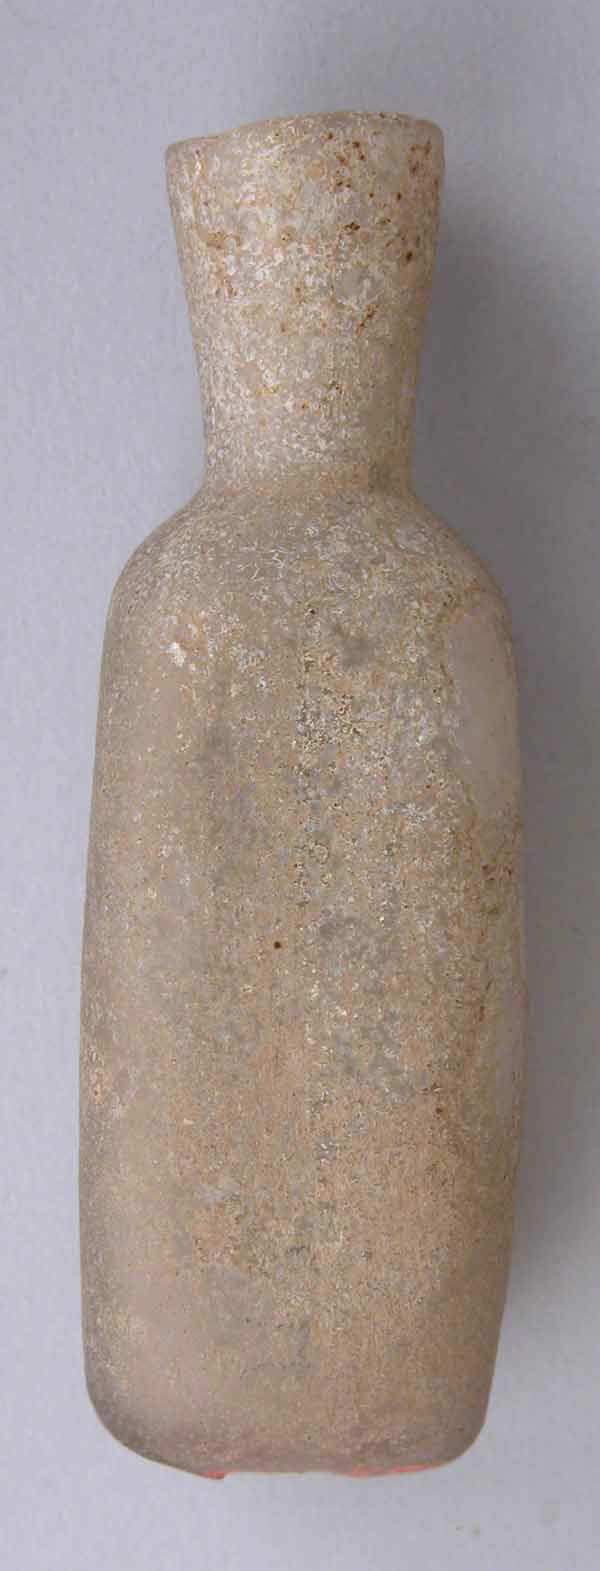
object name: flask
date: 601-800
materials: glass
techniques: glassblowing, tooling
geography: iraq